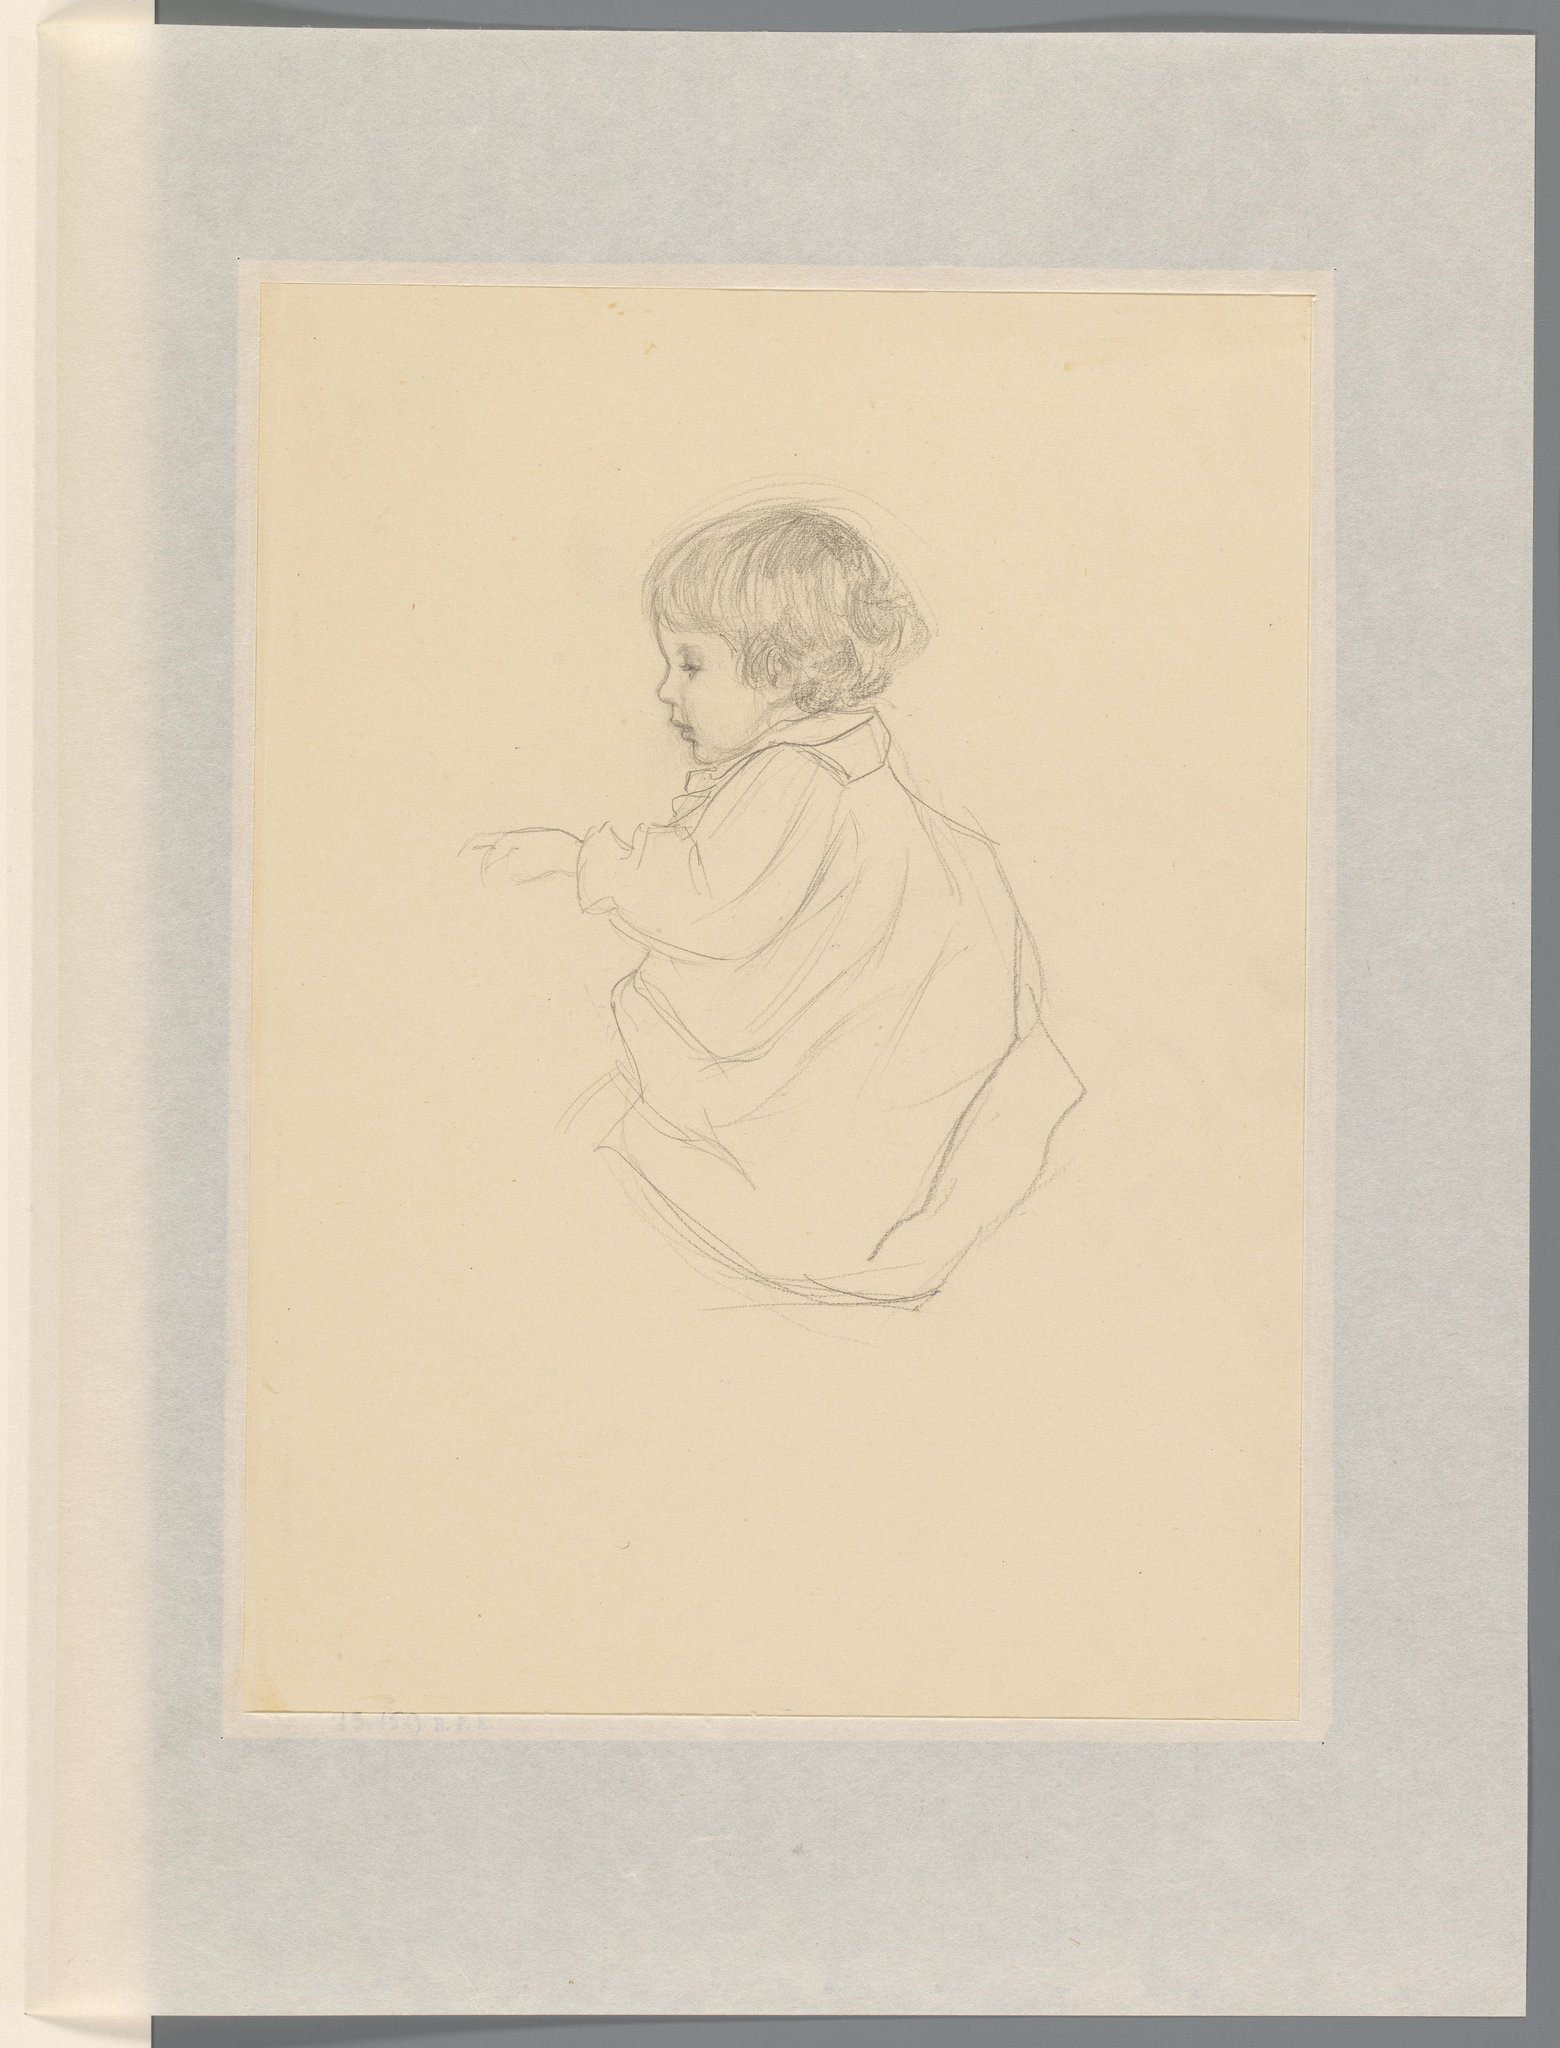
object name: drawing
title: Kinderportret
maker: cornelis spoor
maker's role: draughtsman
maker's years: 1867-1928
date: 1877-1913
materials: chalk, paper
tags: anonymous historical person portrayed alone, girl (child between toddler and youth)